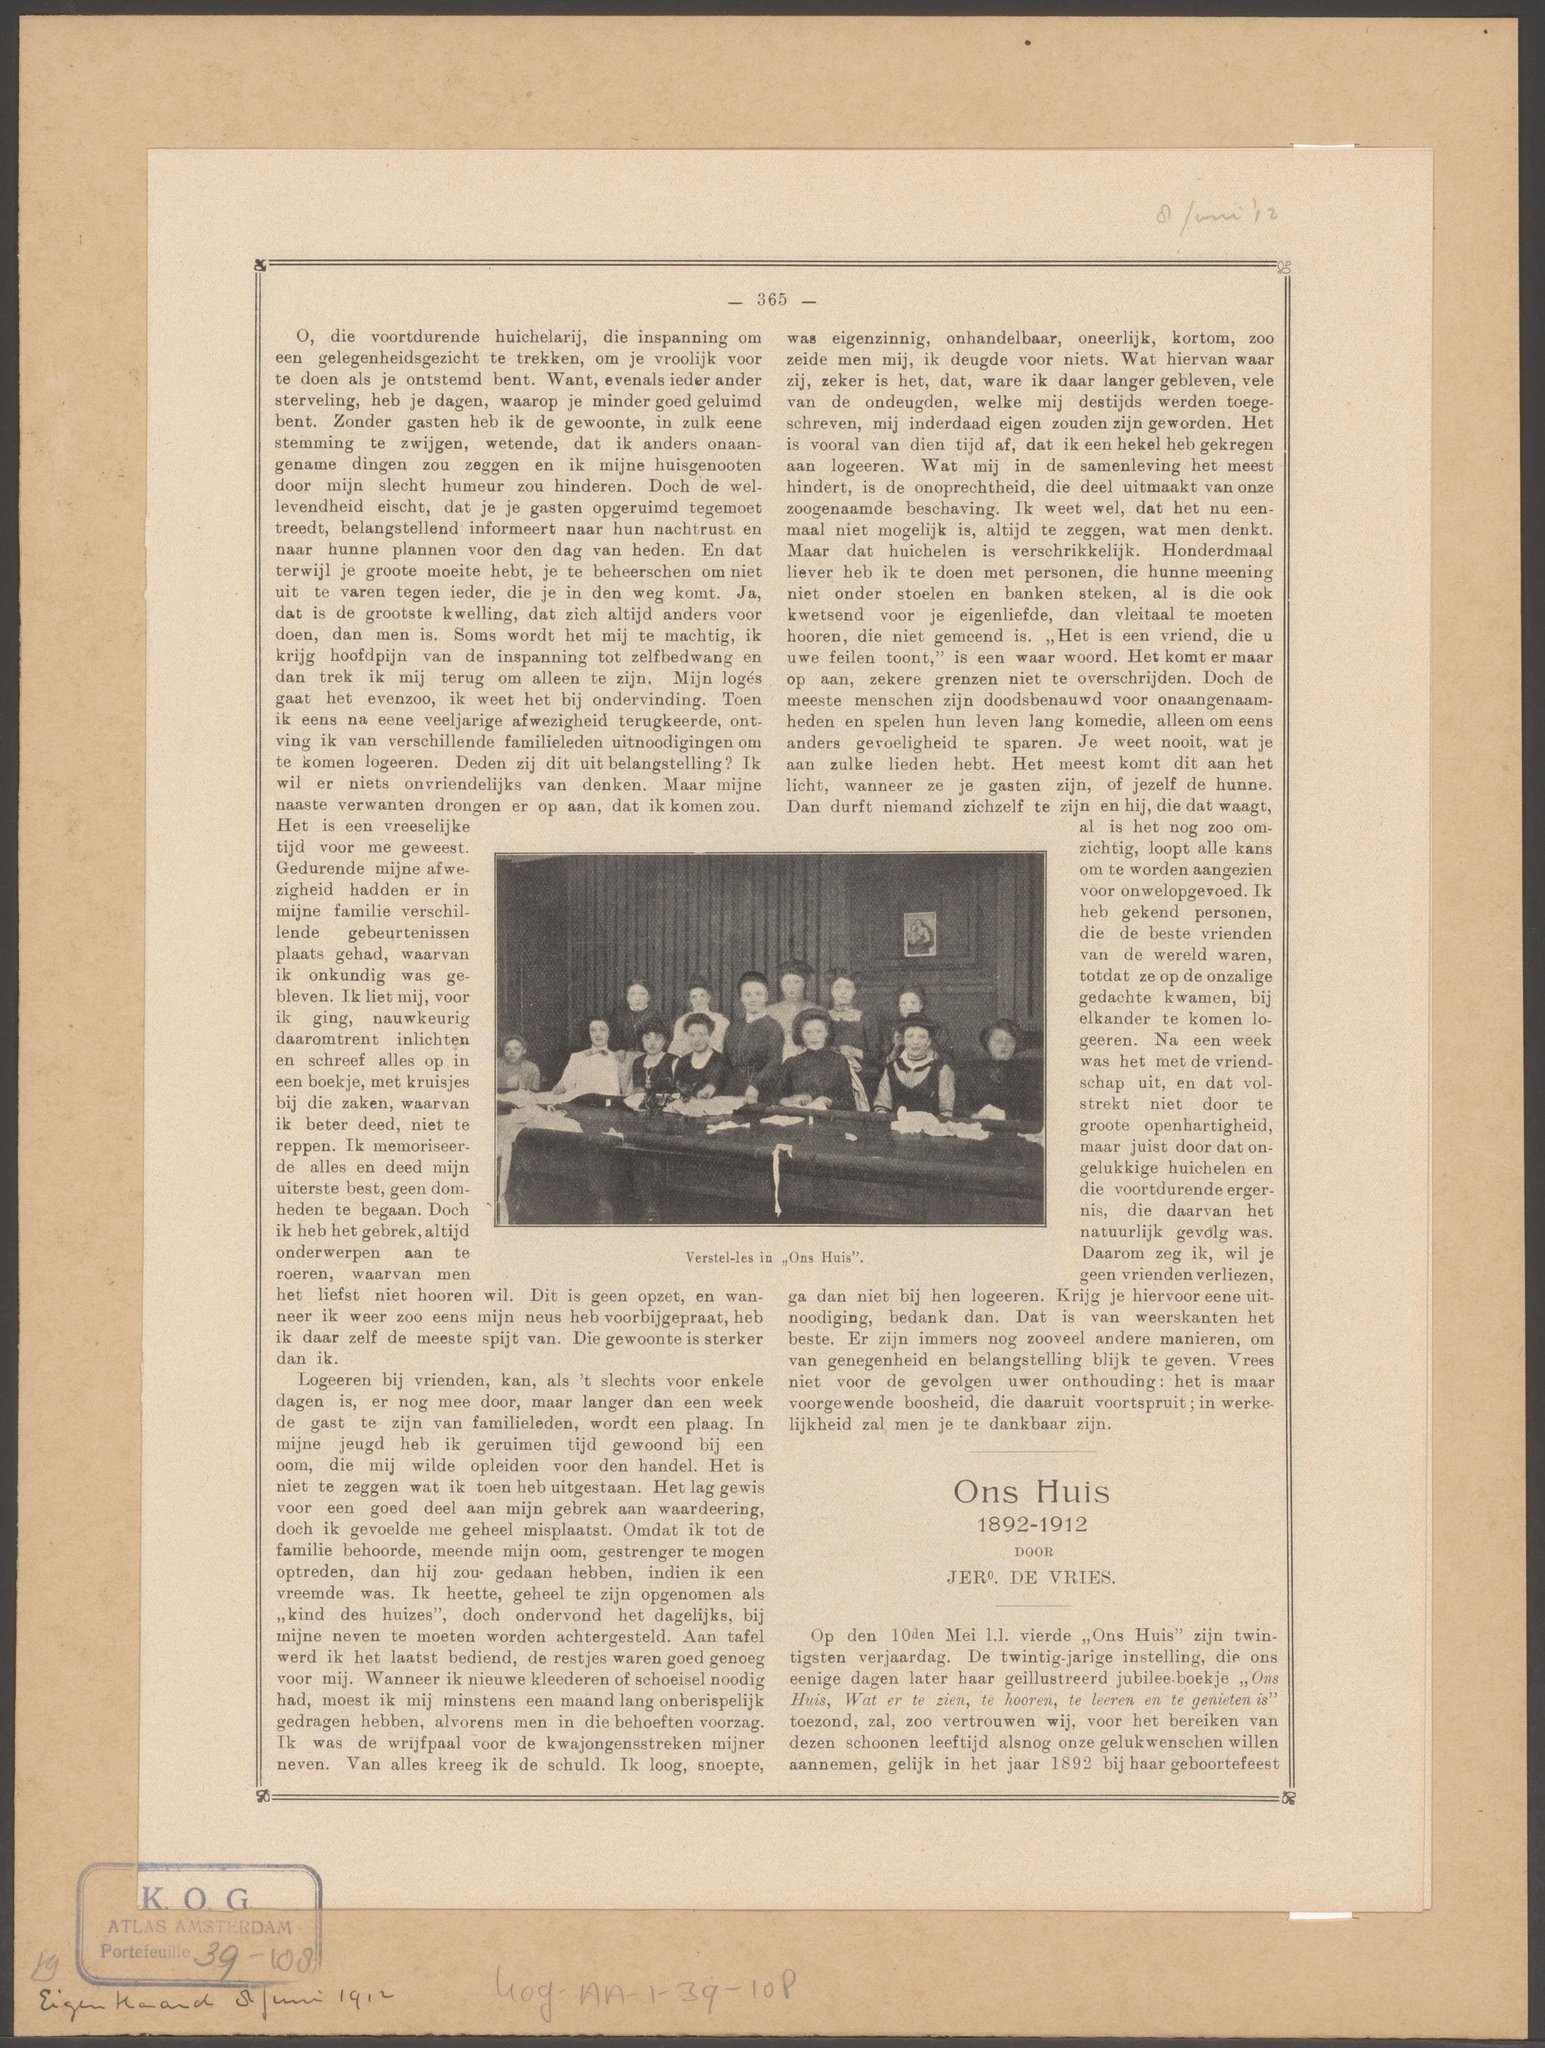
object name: article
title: Artikel over Vereniging Ons Huis te Amsterdam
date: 1912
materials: paper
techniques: letterpress printing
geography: amsterdam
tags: mending, repairing ~ clothes, reading, gymnastic exercises with apparatuses, reading to somebody, writing and letters, flowers: hyacinth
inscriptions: collector's mark: Lugt 1641b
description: Object bestaat uit twee aan elkaar geplakte bladen. Fotomechanische afdrukken met voorstellingen van activiteiten georganiseerd door Vereniging Ons Huis op pagina 365-367. Onderwerpsrubriek binnen de Atlas Amsterdam: Armwezen en liefdadige instellingen: III. Verschillende gestichten en instellingen / Hofjes: Vereeniging Ons Huis.